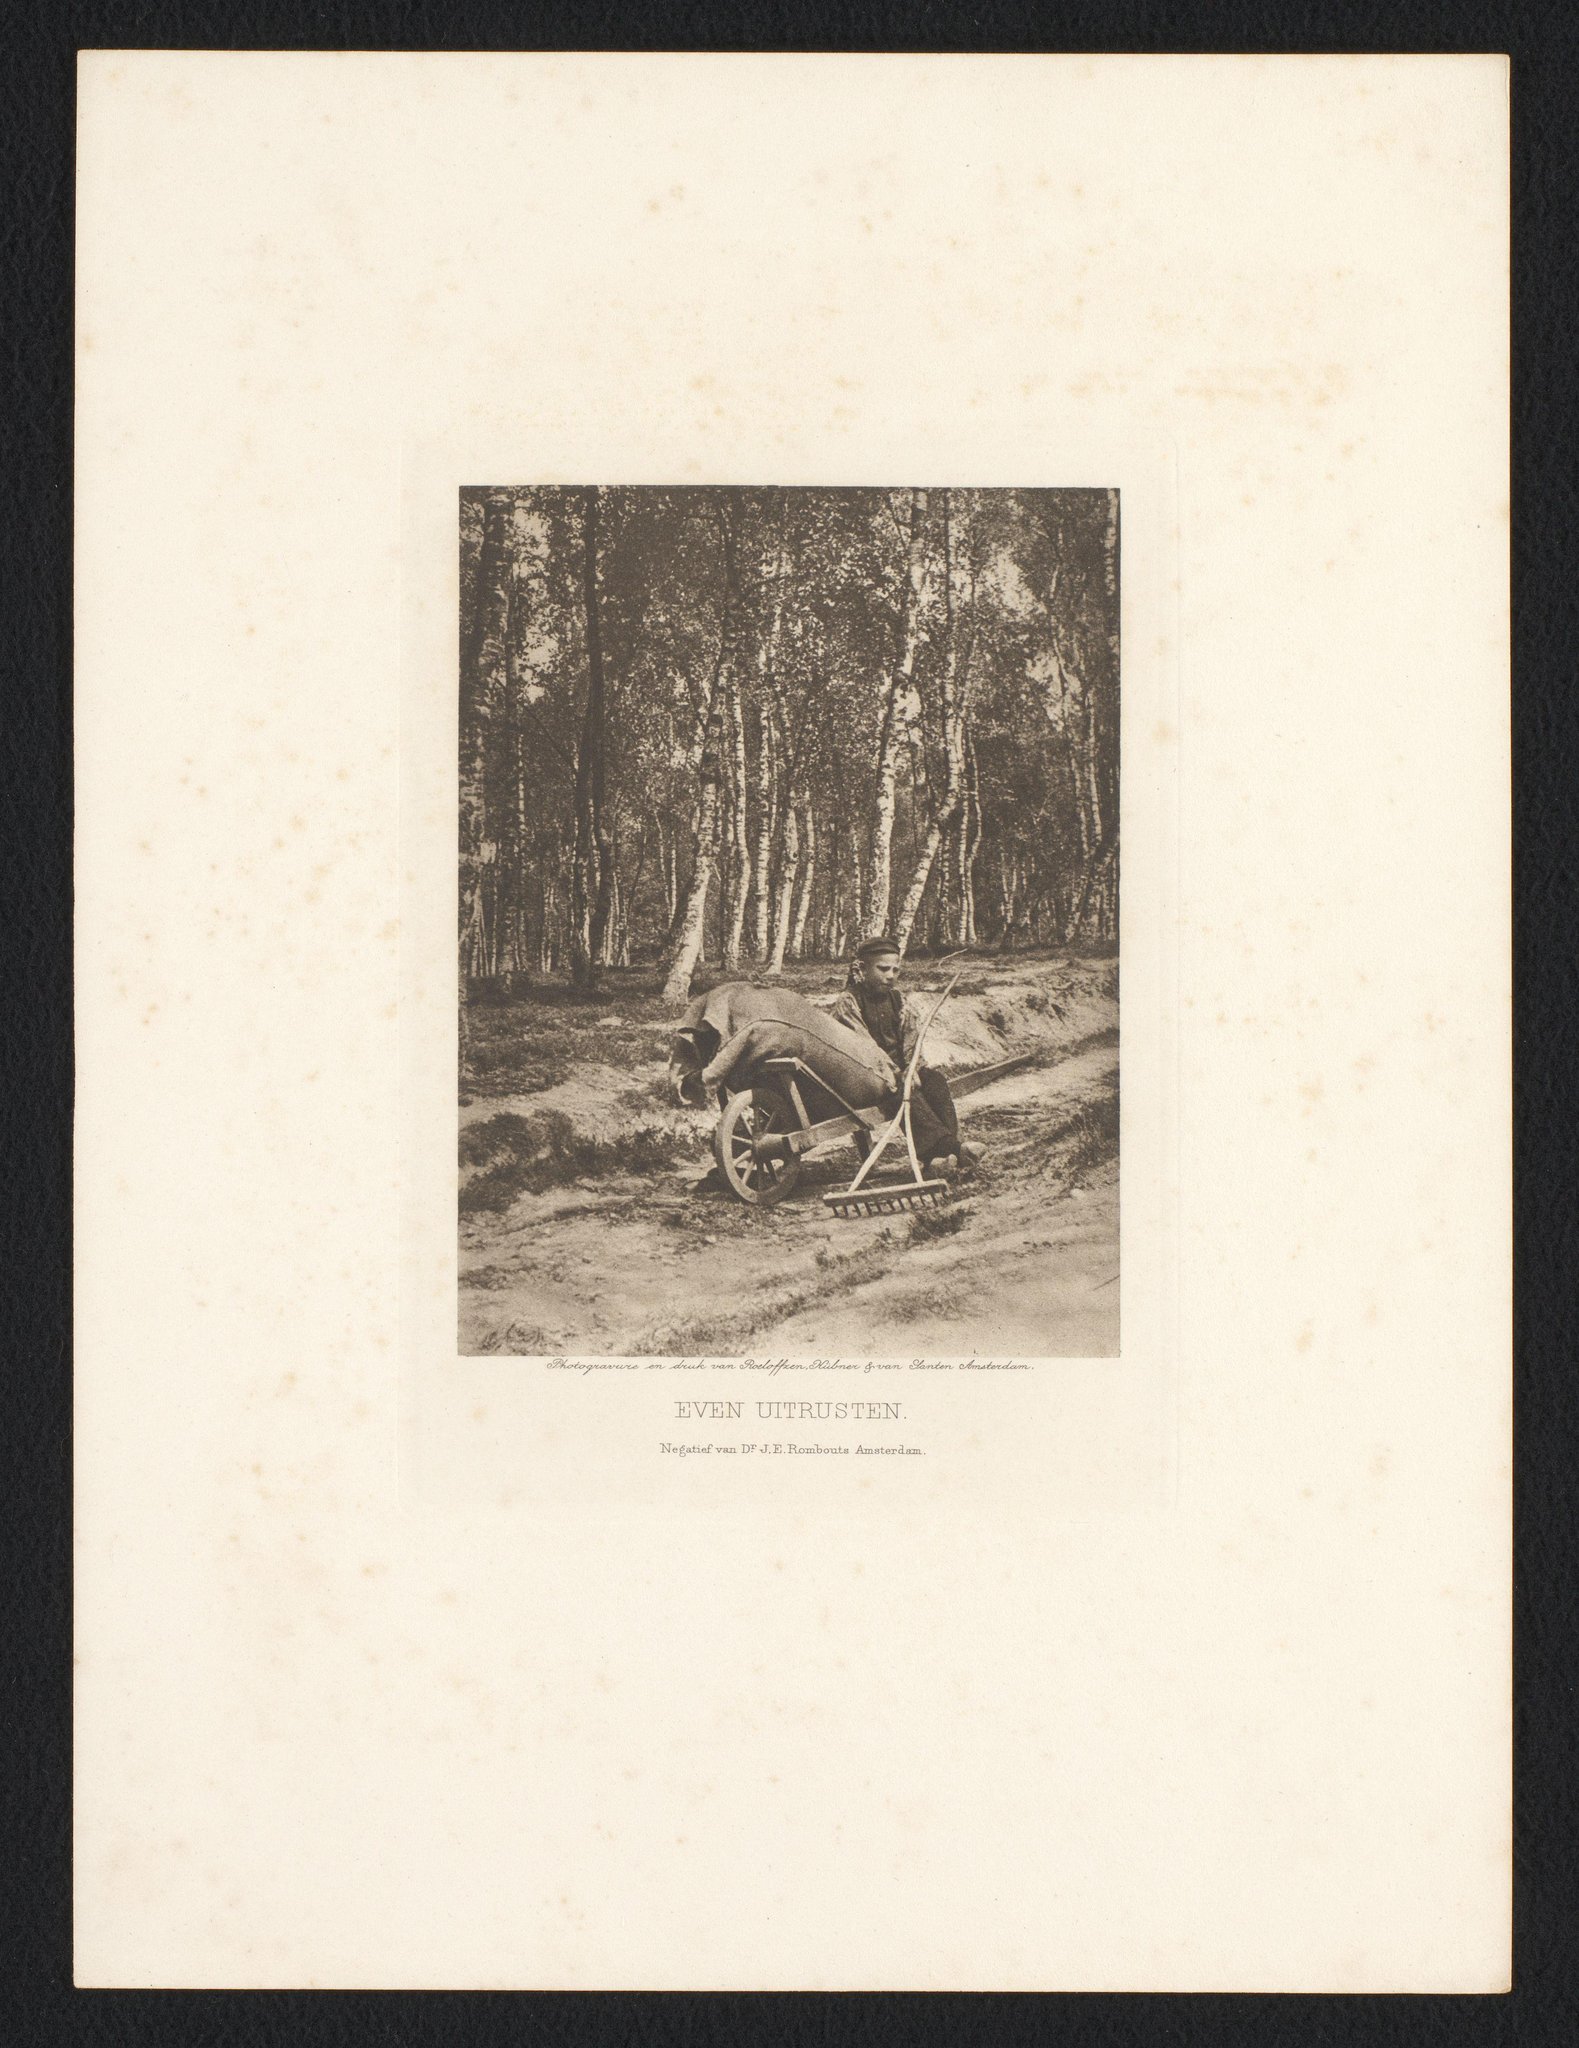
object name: photomechanical print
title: Even uitrusten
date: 1898-1903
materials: paper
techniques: photoaquatint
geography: amsterdam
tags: child, forest, wood